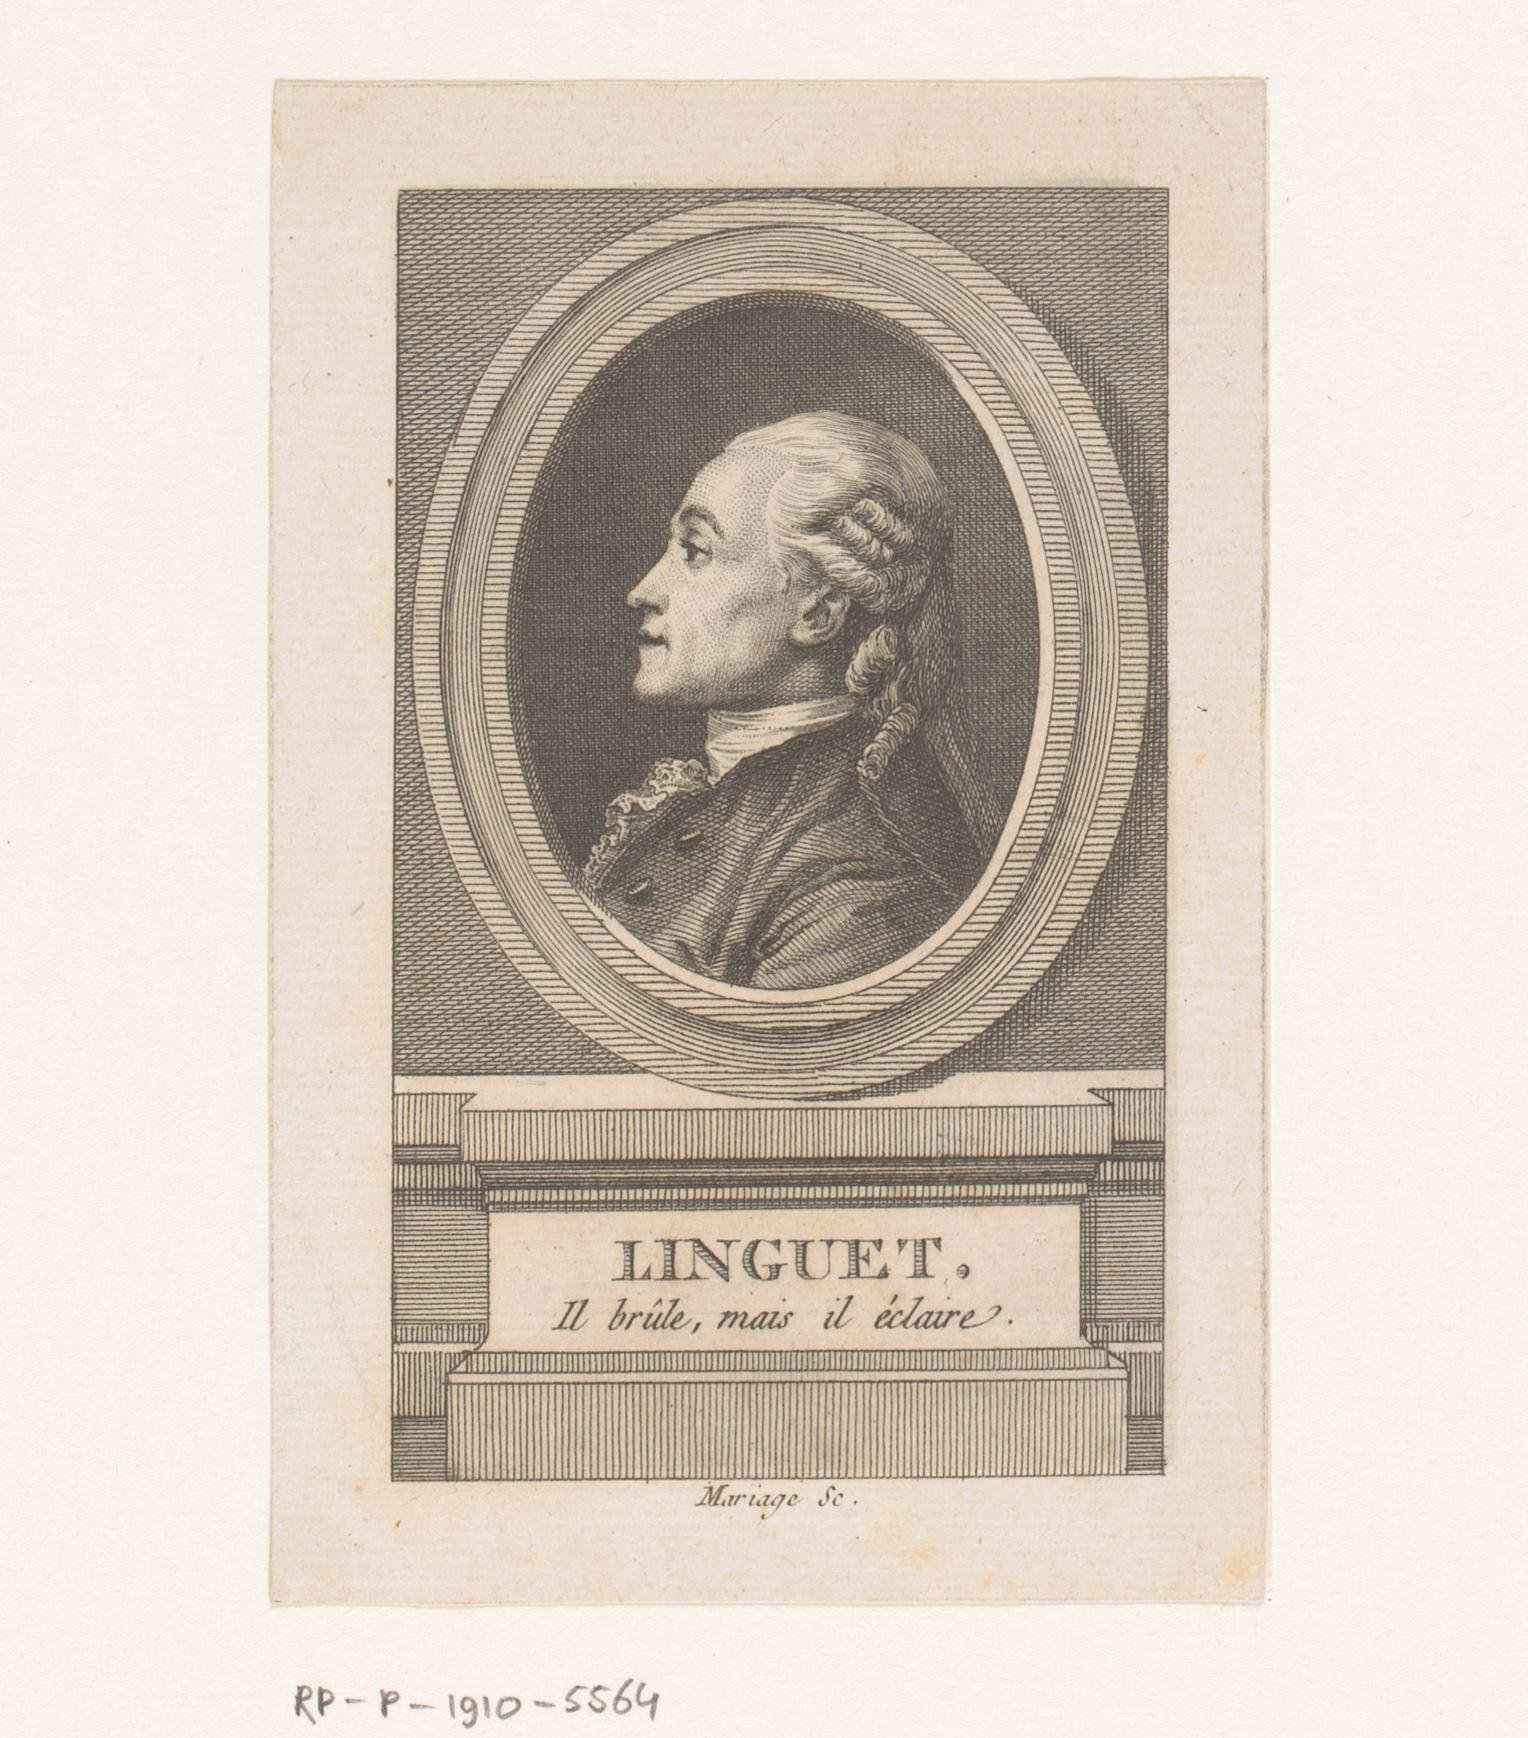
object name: print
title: Portret van Simon-Nicolas Henri Linguet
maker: louis françois mariage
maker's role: print maker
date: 1785-1828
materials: paper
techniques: etching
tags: paris, historical persons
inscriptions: collector's mark: Lugt 2228